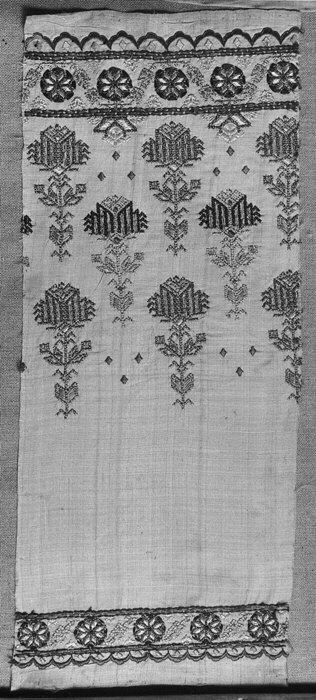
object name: fragment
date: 1801-1900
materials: silk